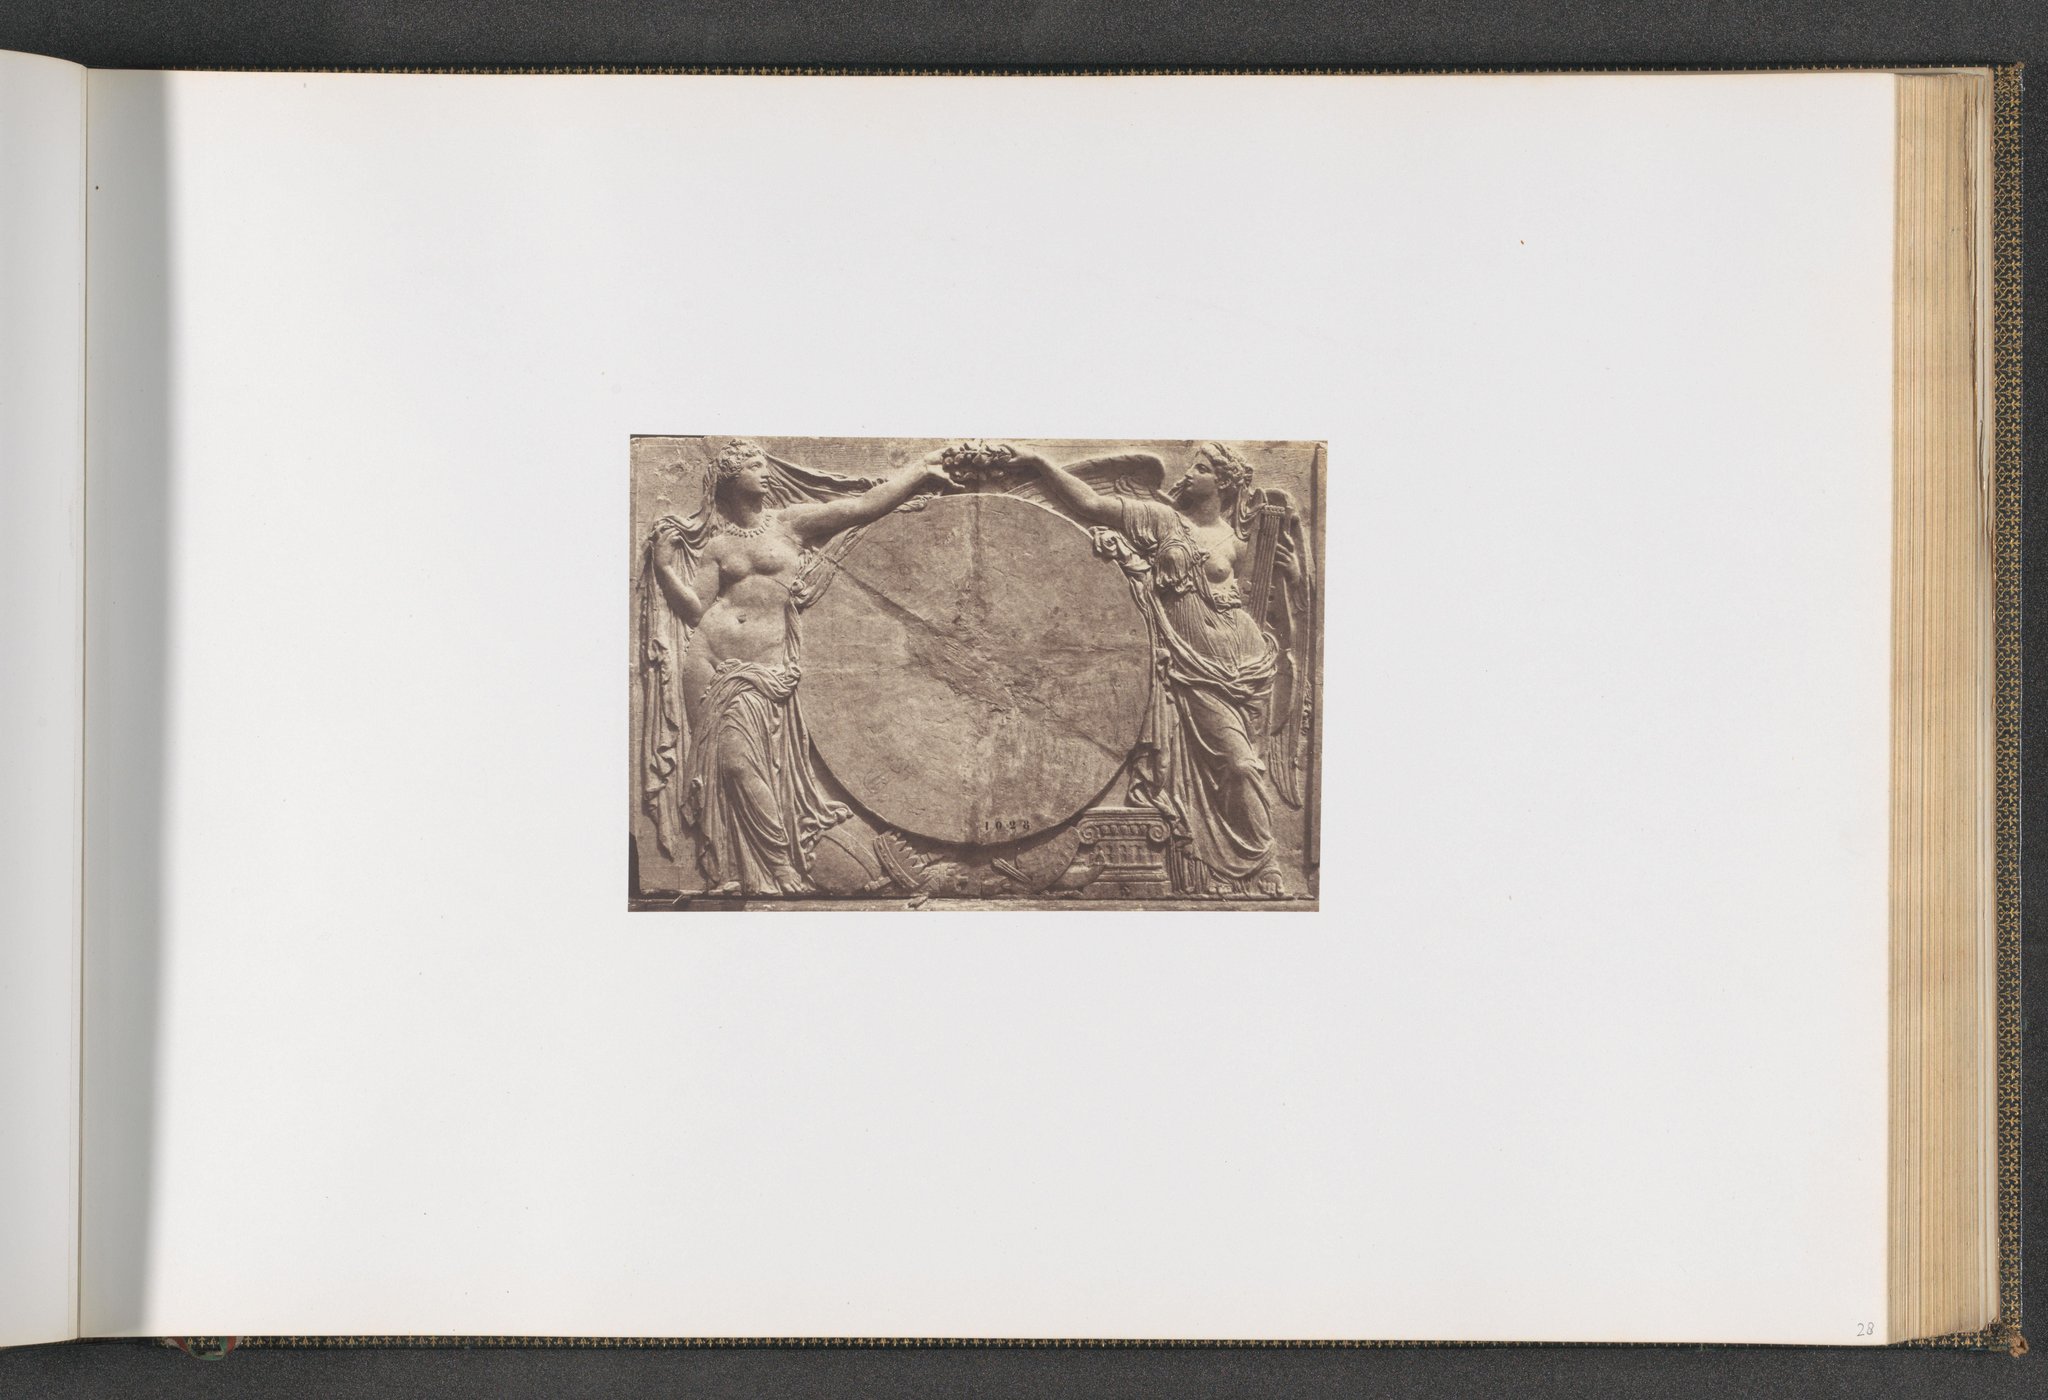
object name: photograph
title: Gipsmodel voor beeldhouwwerk op het Palais du Louvre: "La Beauté et l'Art" door Eugène Guillaume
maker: édouard denis baldus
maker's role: fotograaf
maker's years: 1813-1889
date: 1855-1857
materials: paper, photographic support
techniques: salted paper print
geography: paris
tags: piece of sculpture, reproduction of a piece of sculpture, permanent exhibition, museum, paris, tuileries palace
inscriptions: number: ‘1028’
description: Onderdeel van Réunion des Tuileries au Louvre 1852-1857, album 2.